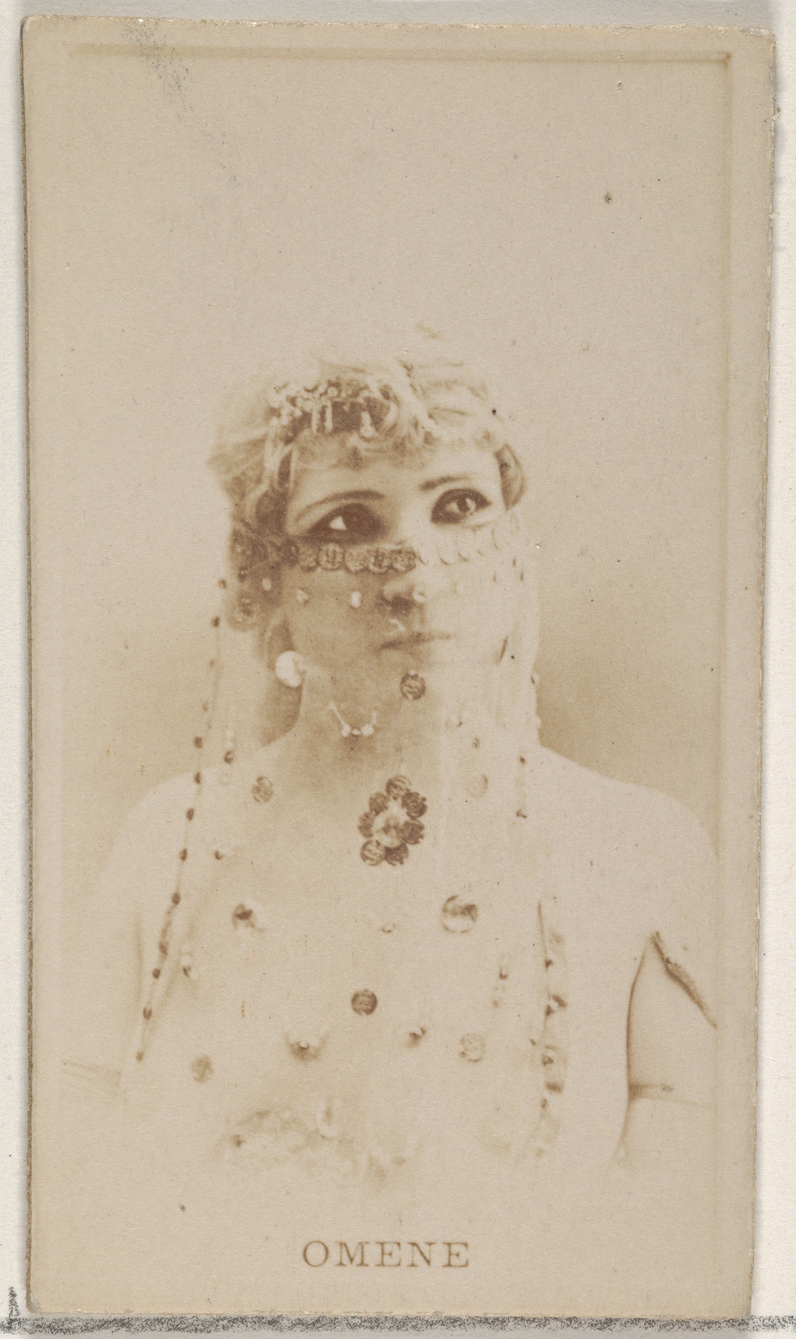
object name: photograph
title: Omene, from the Actors and Actresses series (N45, Type 8) for Virginia Brights Cigarettes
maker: allen & ginter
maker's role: publisher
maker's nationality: american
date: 1888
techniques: albumen silver print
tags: portraits,women,actresses